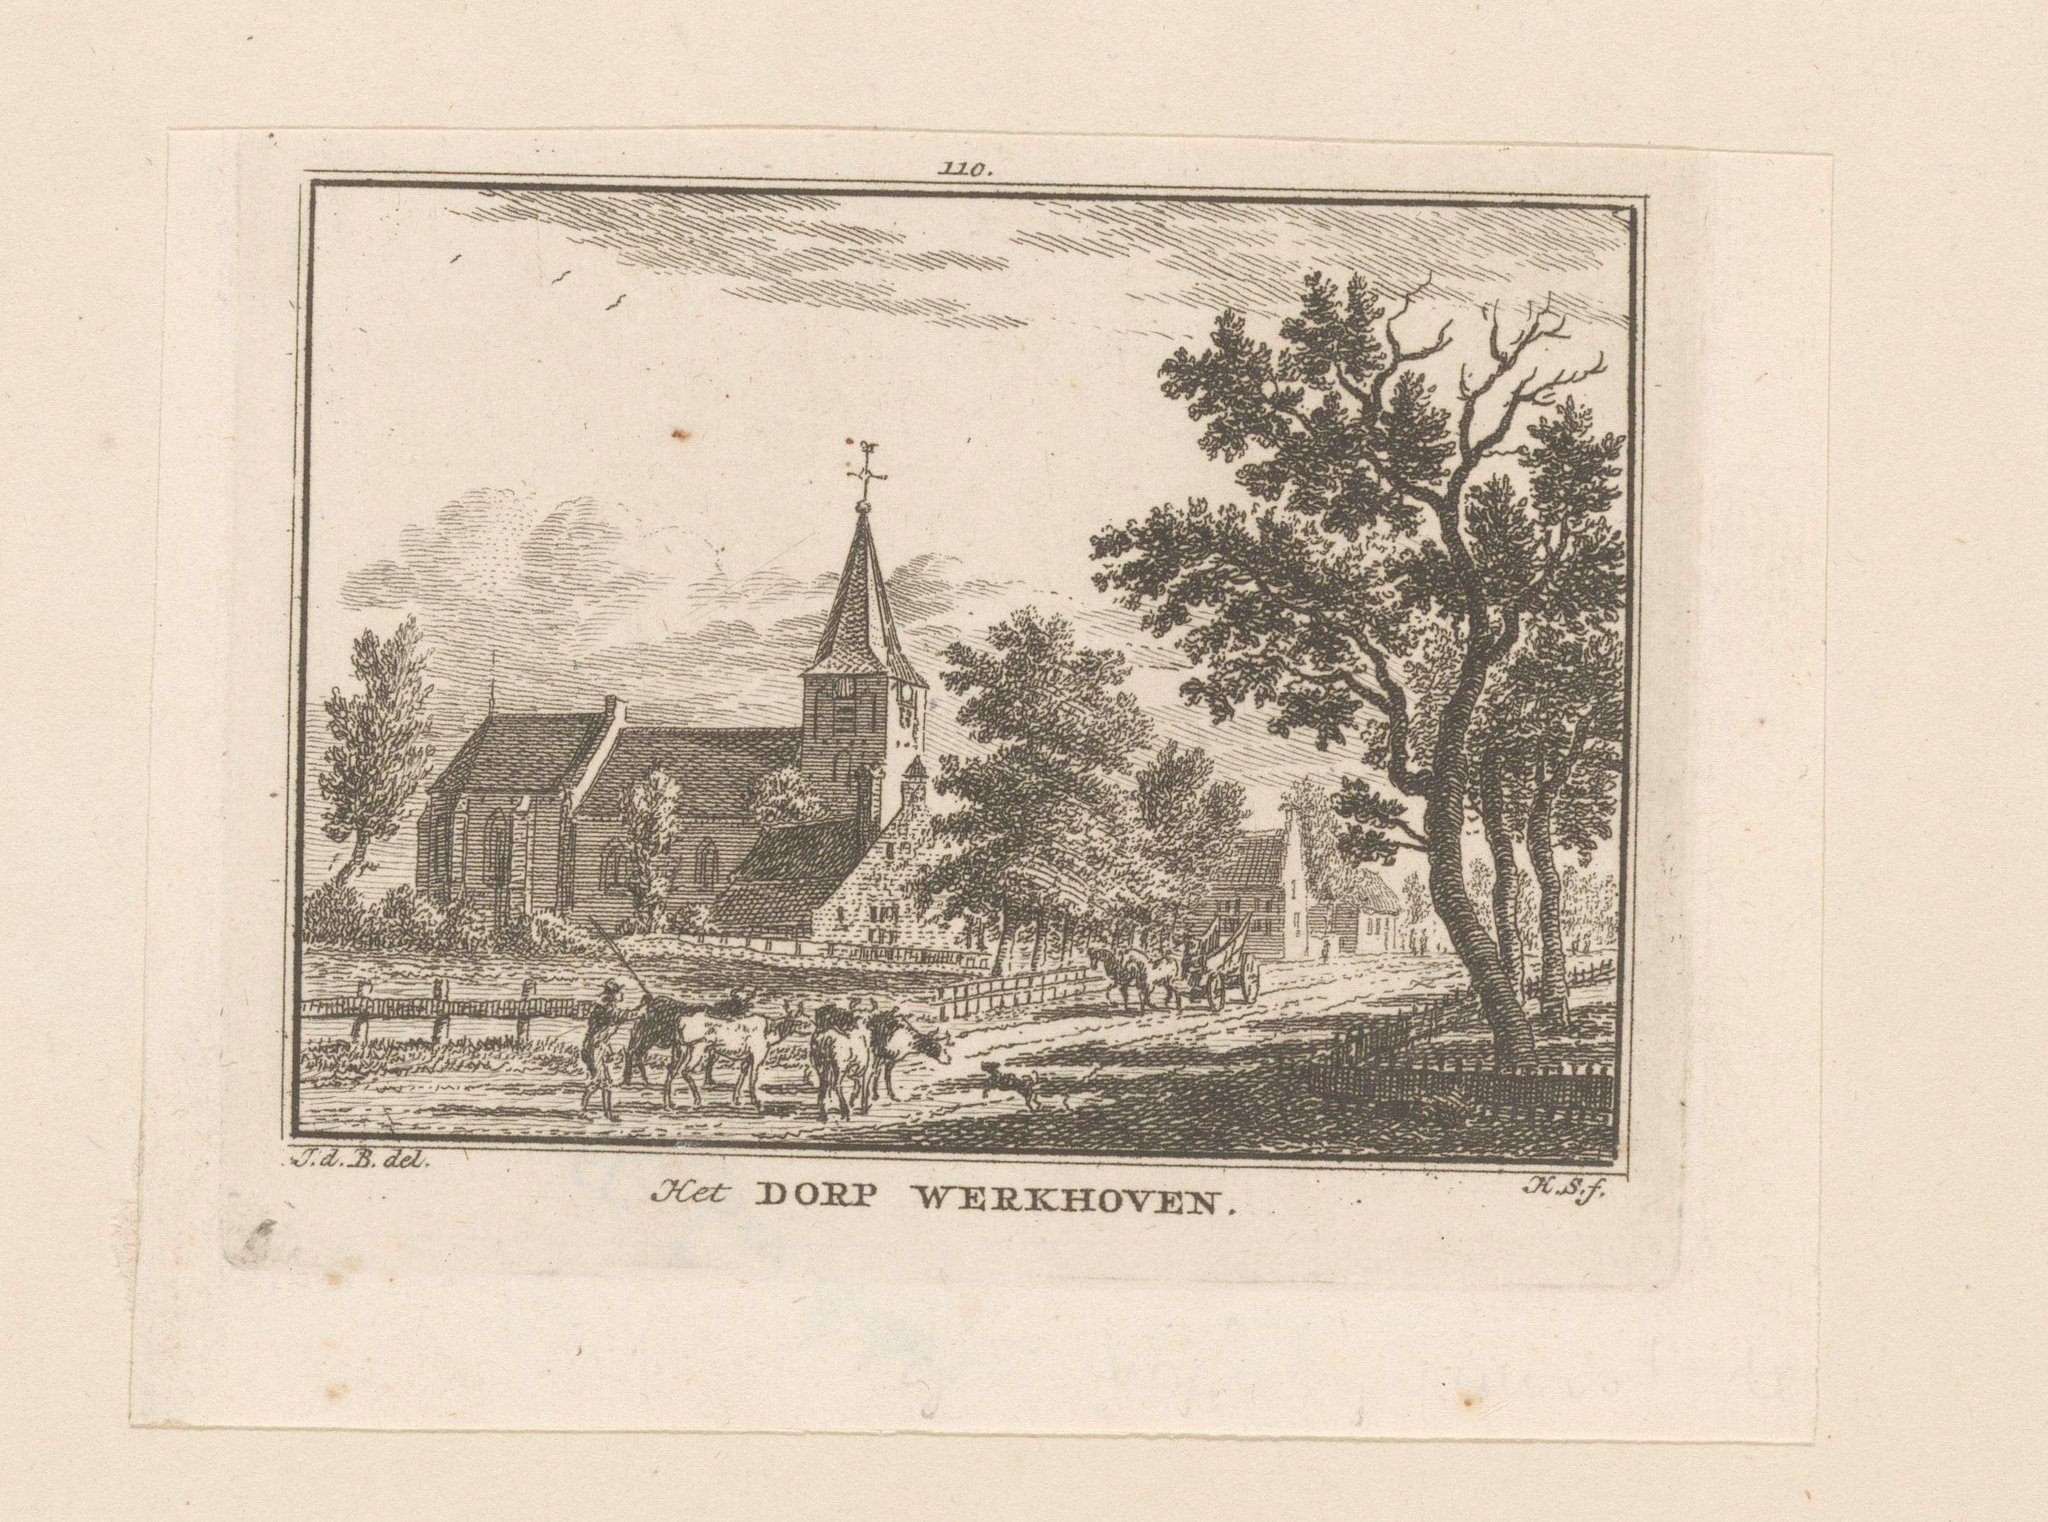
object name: book illustration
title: Gezicht op het dorp Werkhoven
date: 1745-1774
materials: paper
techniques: engraving, etching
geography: utrecht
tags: village, church (exterior)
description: Prent uit: Spilman, Hendrik. Het verheerlykt Nederland; of, kabinet van hedendaagsche gezigten (...). 9 dln. Amsterdam: Isaak Tirion, 1745-1774.